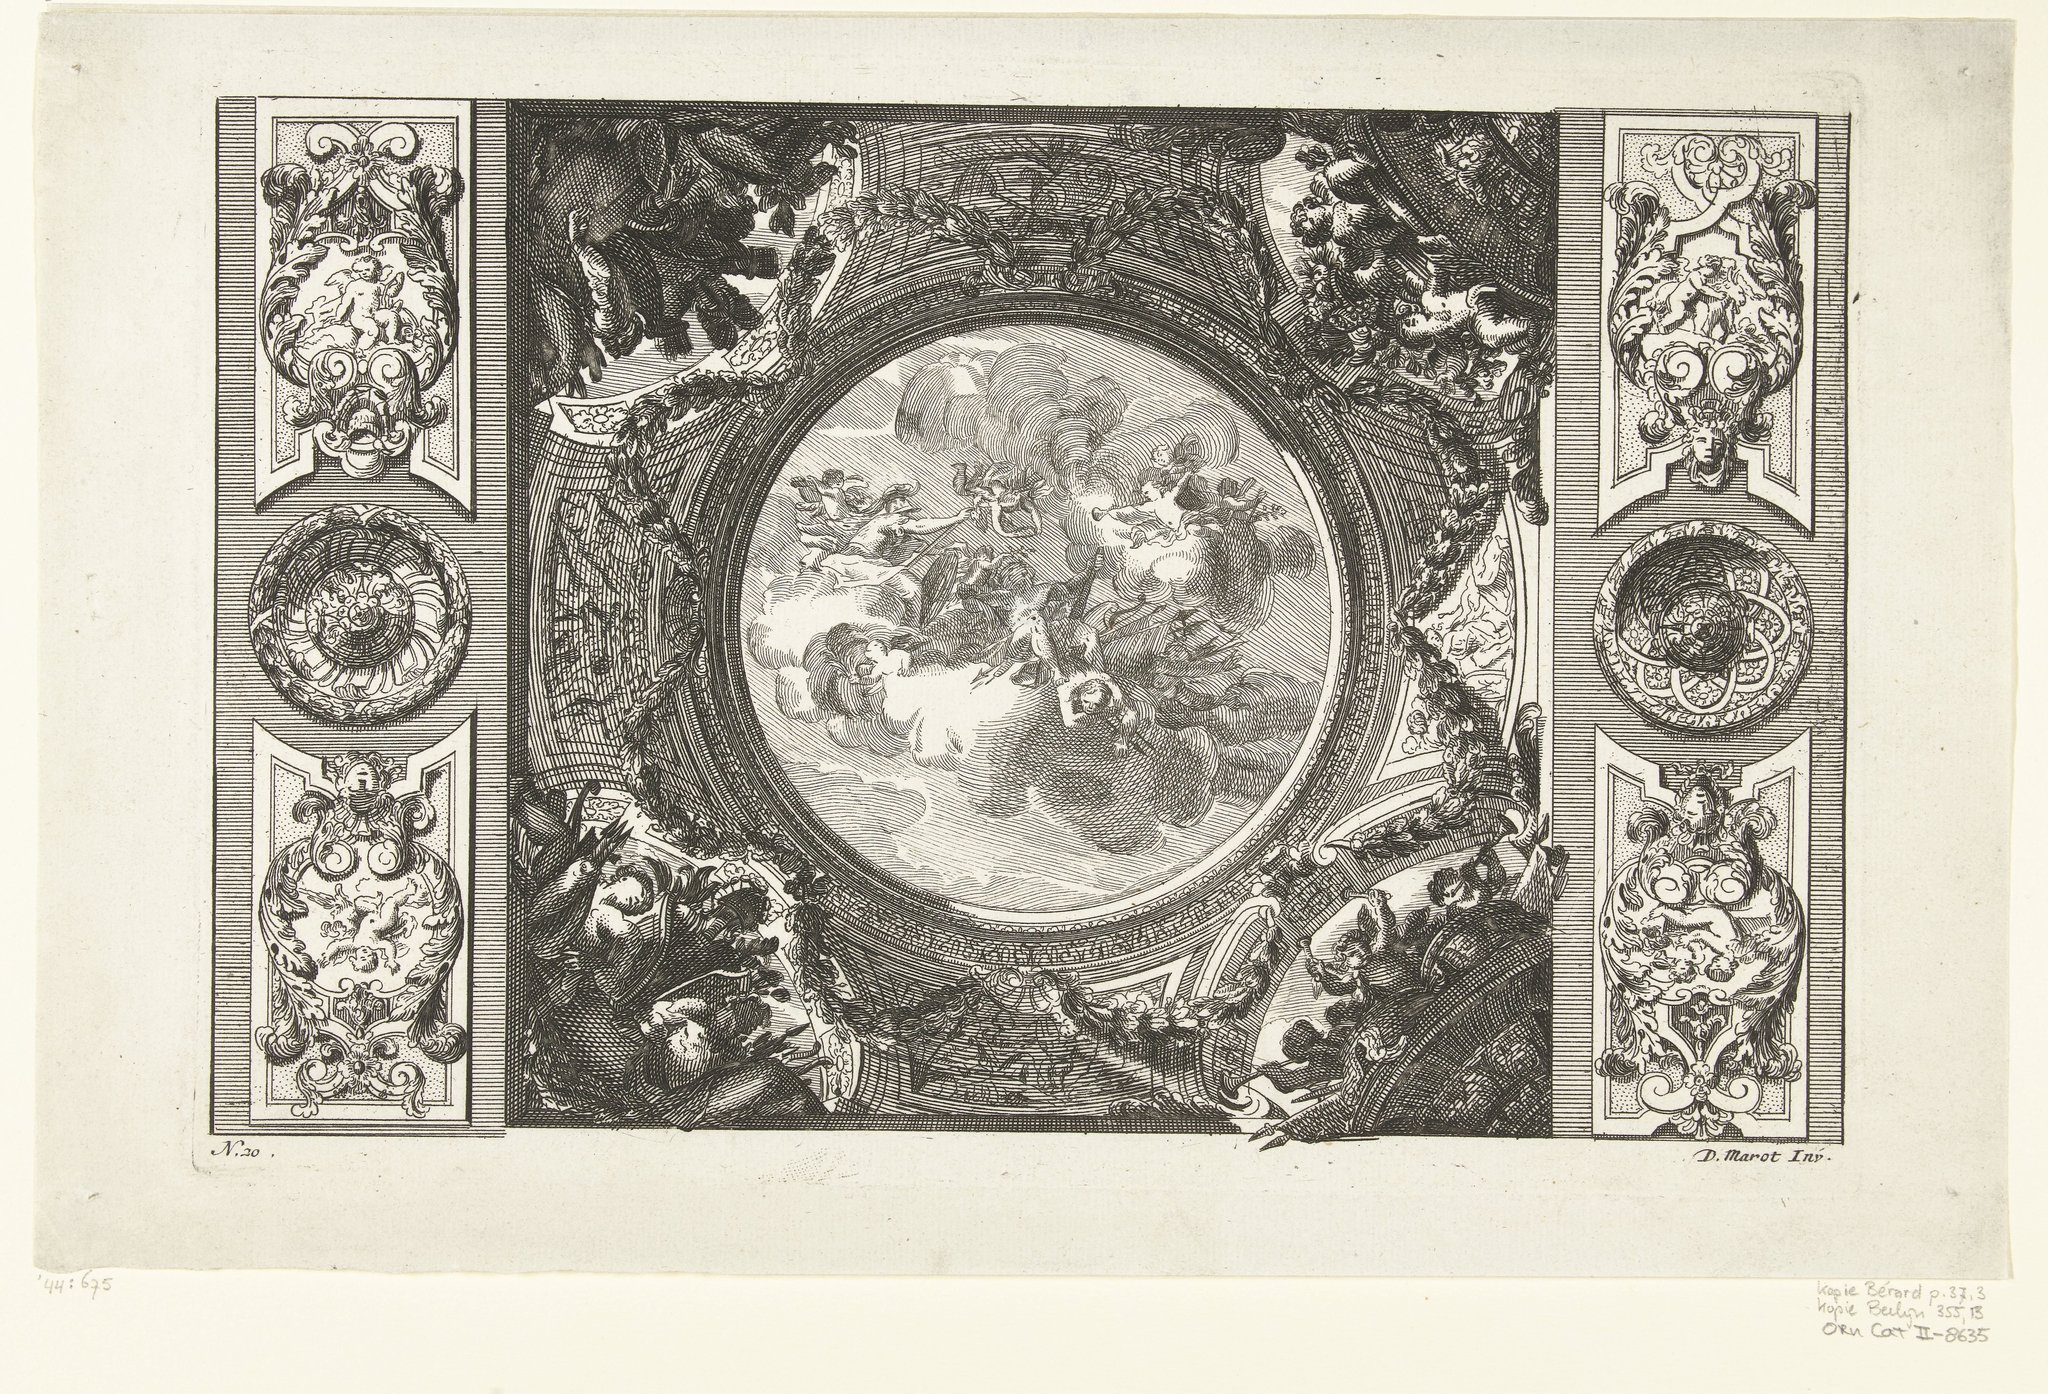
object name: print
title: Vierkant plafond met Hercules en Minerva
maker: Anonymous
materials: paper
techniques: etching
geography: netherlands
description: Vierkant plafond met rond paneel met kroning van Hercules door Minerva. In de hoeken vier bogen met putti en wapentrofeeën geflankeerd door zittende figuren. Aan de zijkanten een brede balk met rozetten en medaillons met putti. Tegenzijdige kopie naar prent uit serie met plafonds ontworpen en uitgegeven door Daniel Marot.